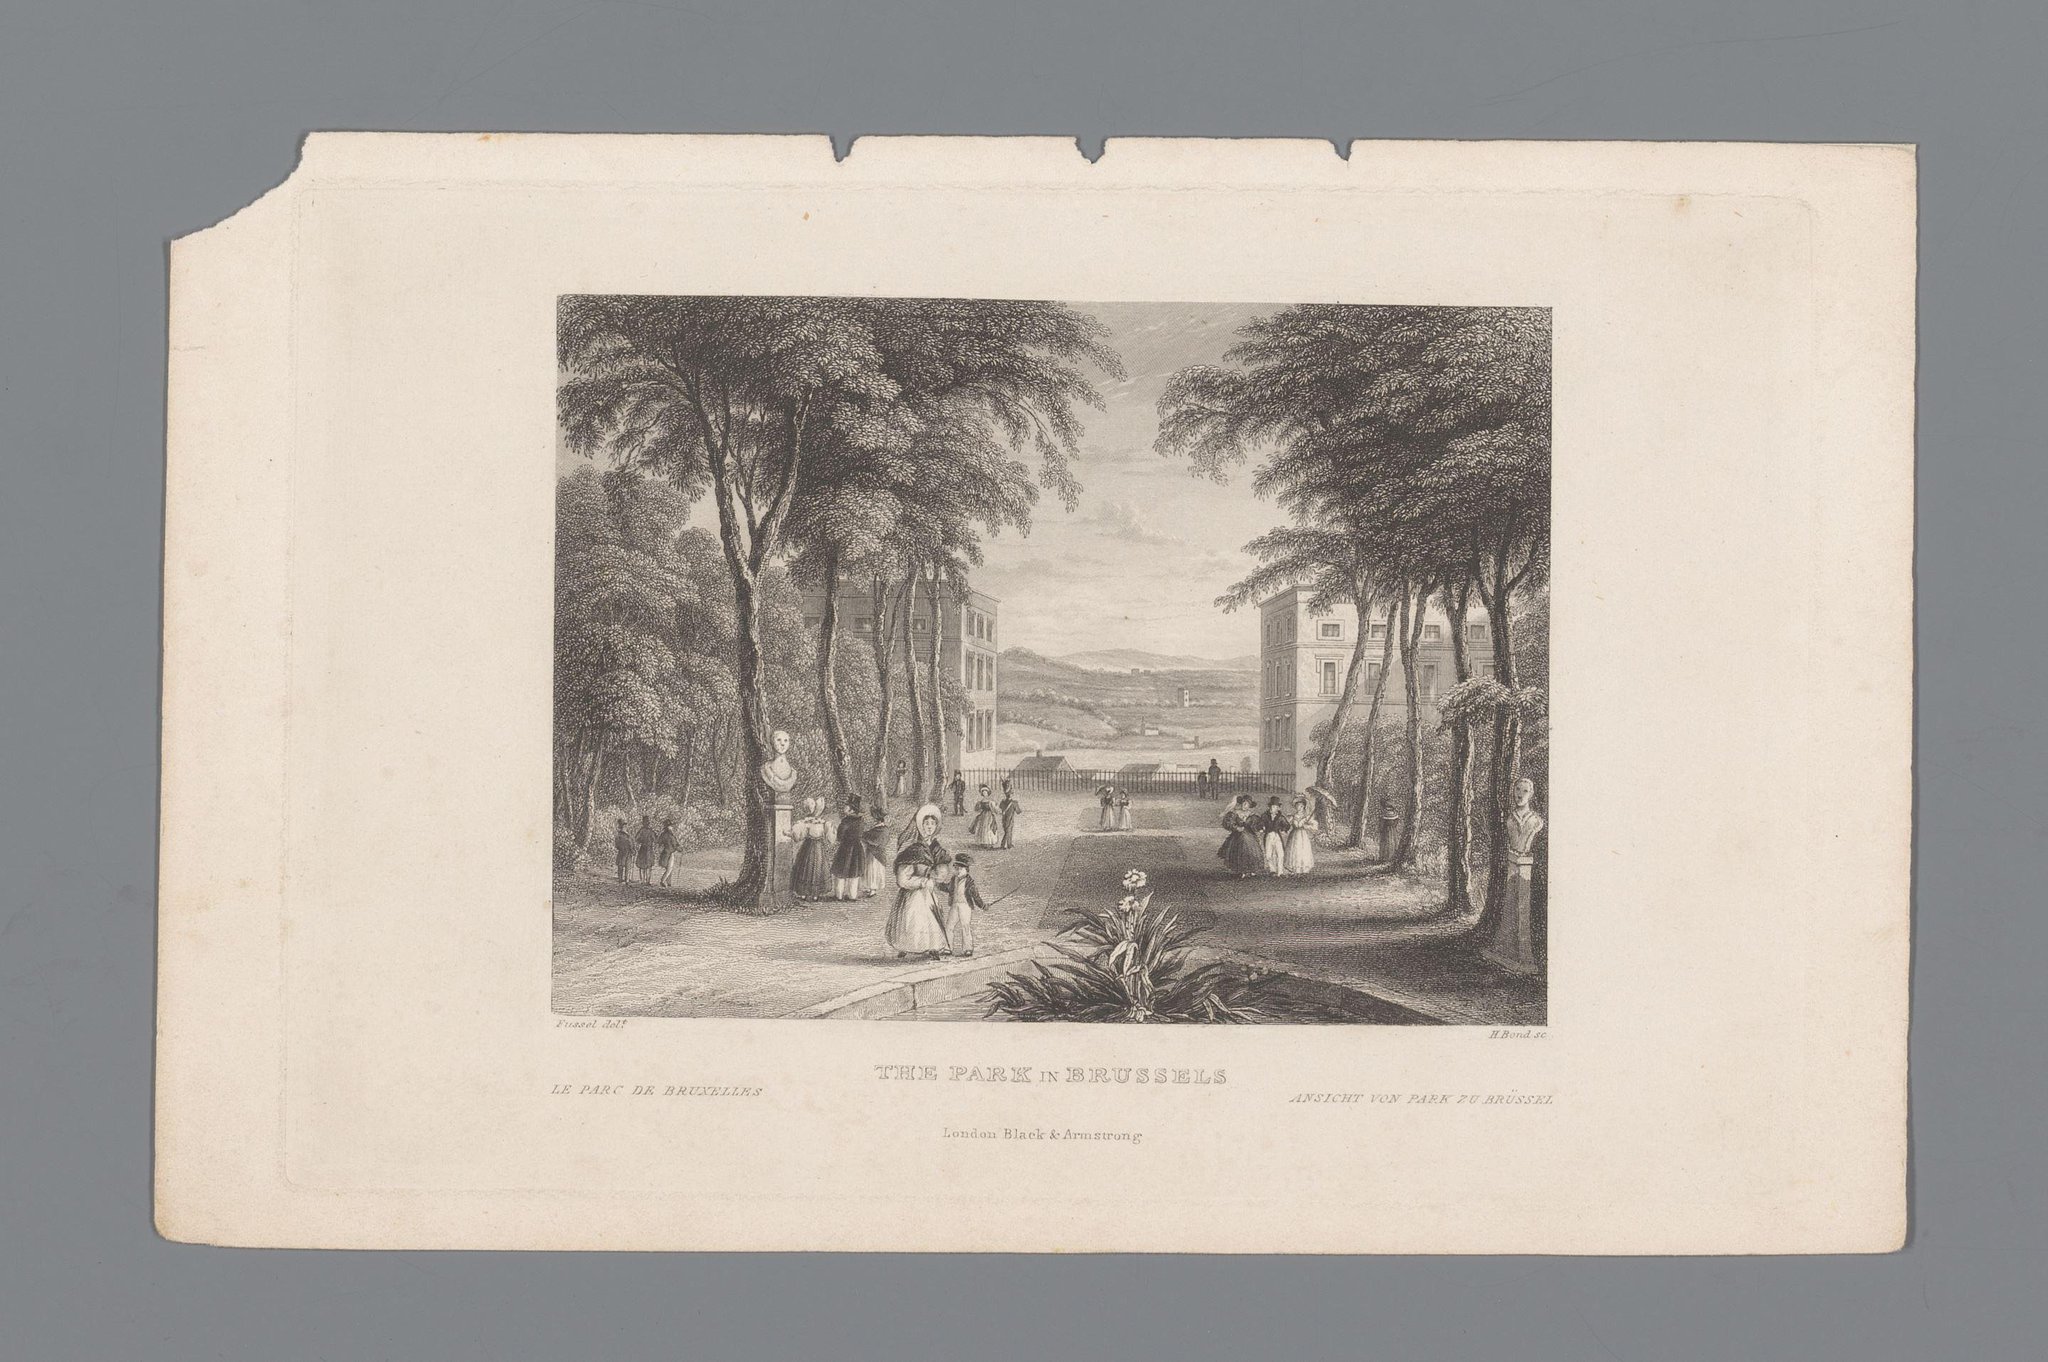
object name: print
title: The park in Brussels / Le parc de Bruxelles / Ansicht von park zu Brüssel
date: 1800-1875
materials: paper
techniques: engraving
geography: london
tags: public gardens, park, brussels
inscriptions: collector's mark: Lugt 2233